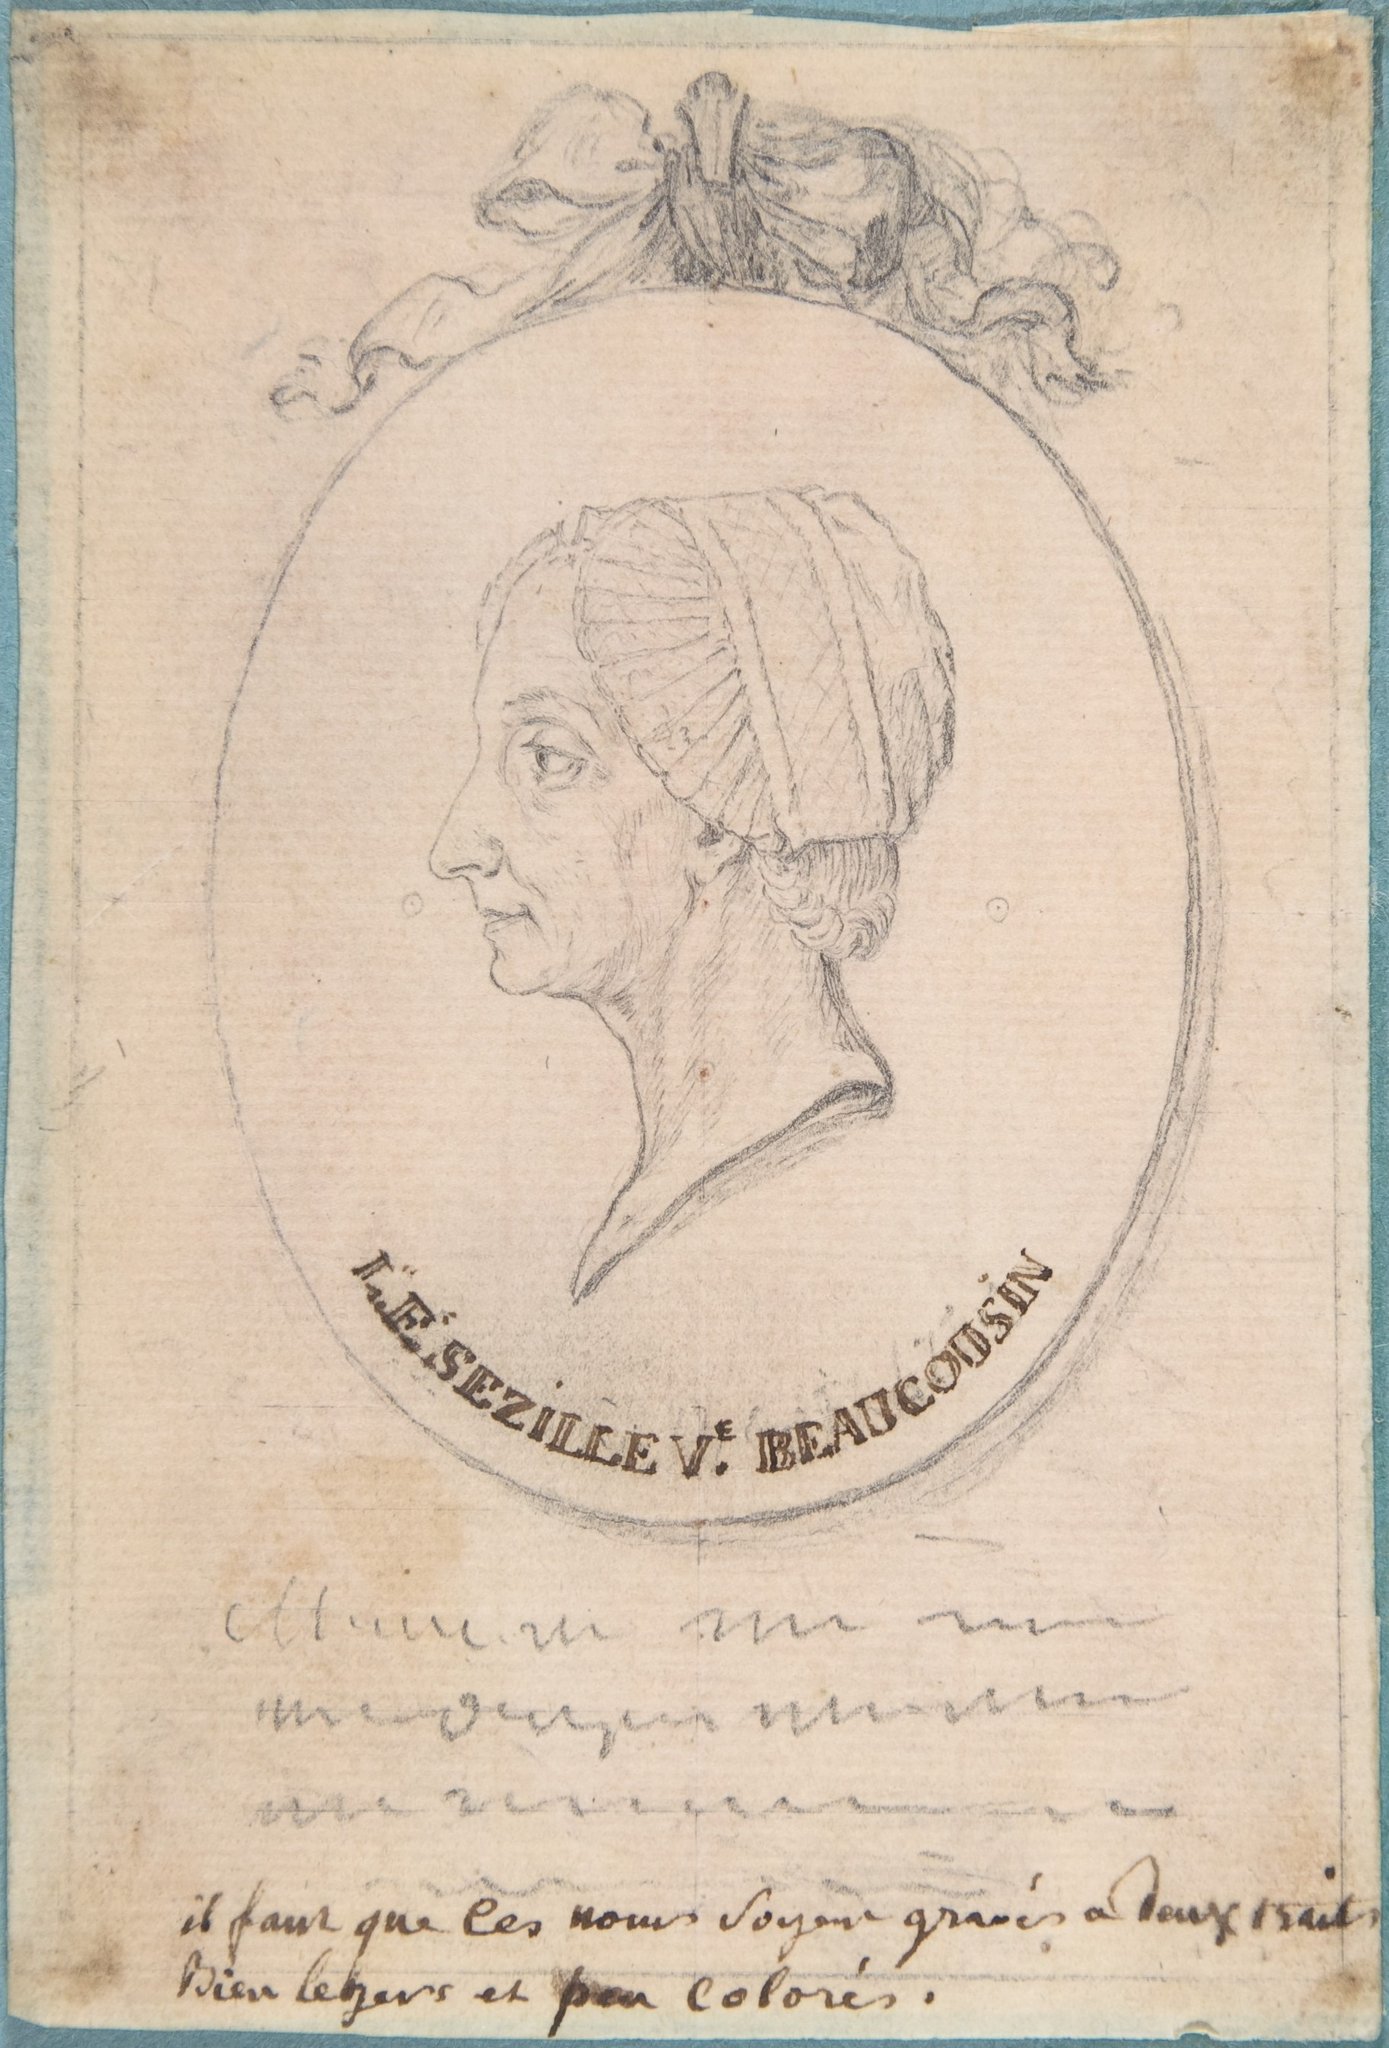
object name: drawing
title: Portrait of L. F. Sezille, Widow of Beaucousin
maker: anonymous, french, 18th century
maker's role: artist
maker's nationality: french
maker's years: 1700-1800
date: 1701-1800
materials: graphite, ink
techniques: pen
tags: profiles,women